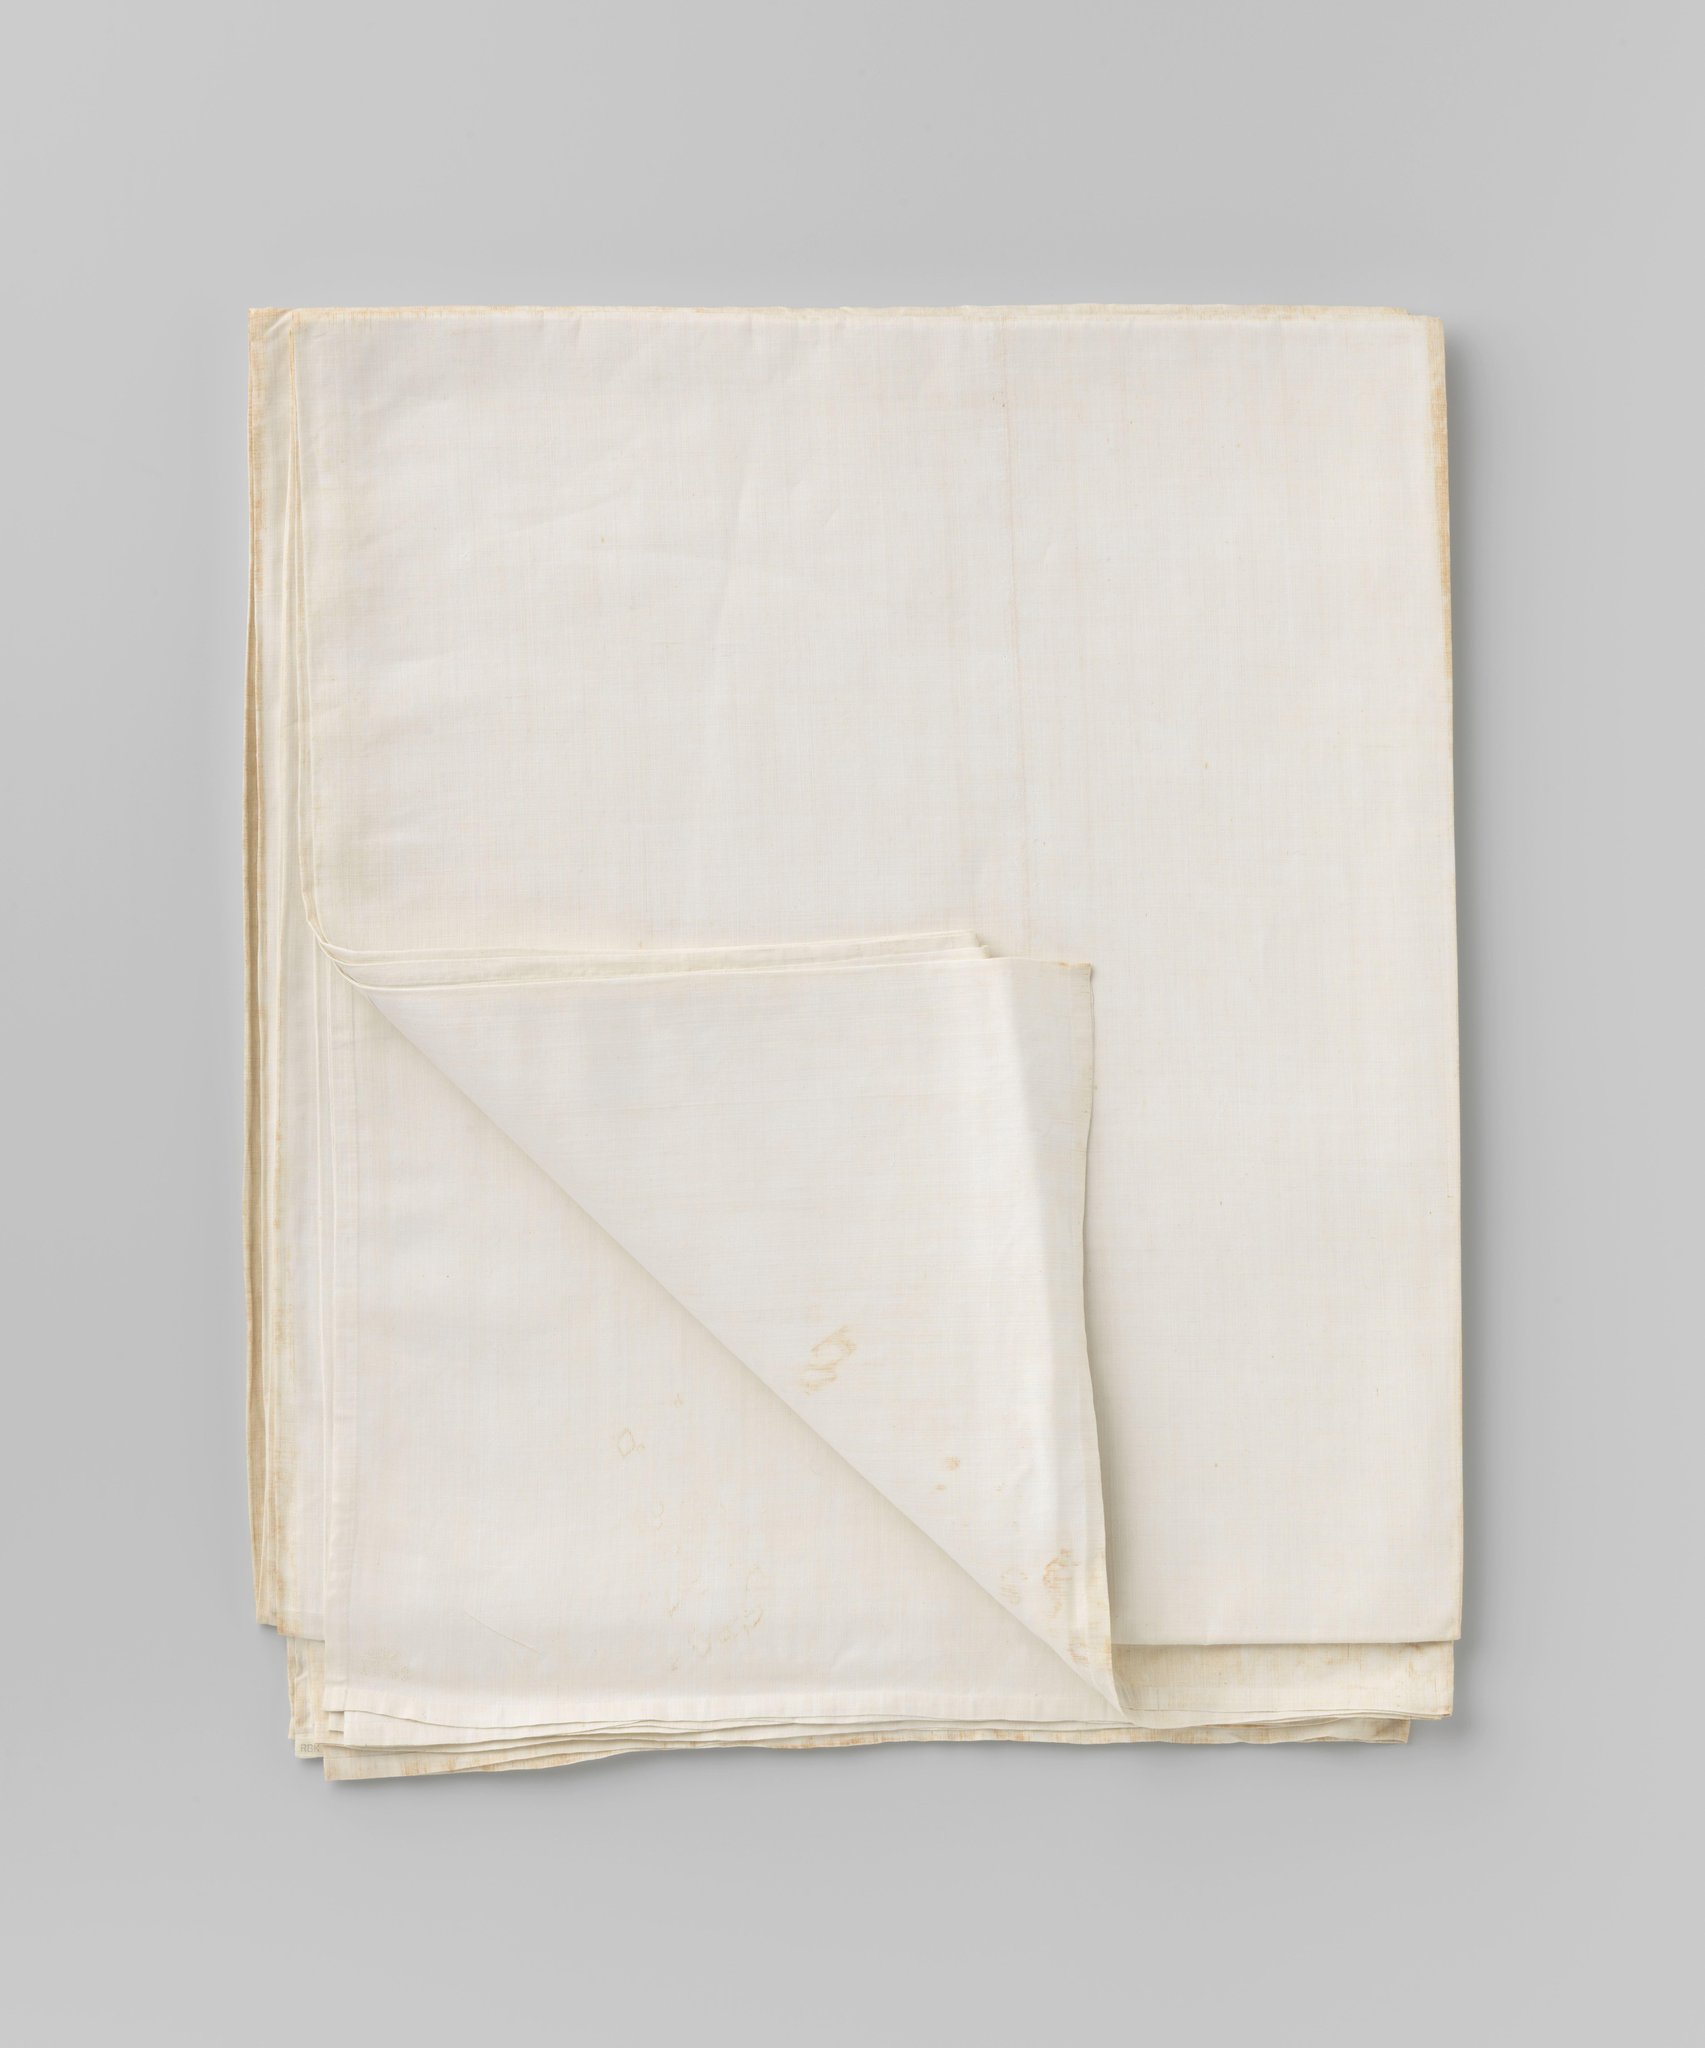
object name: beddenlaken, laken object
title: Laken. Merk: kroon IIVG en ?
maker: Anonymous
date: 1692-1735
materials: linen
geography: northern netherlands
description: Laken van wit linnen, merk kroon IIVG en (?)